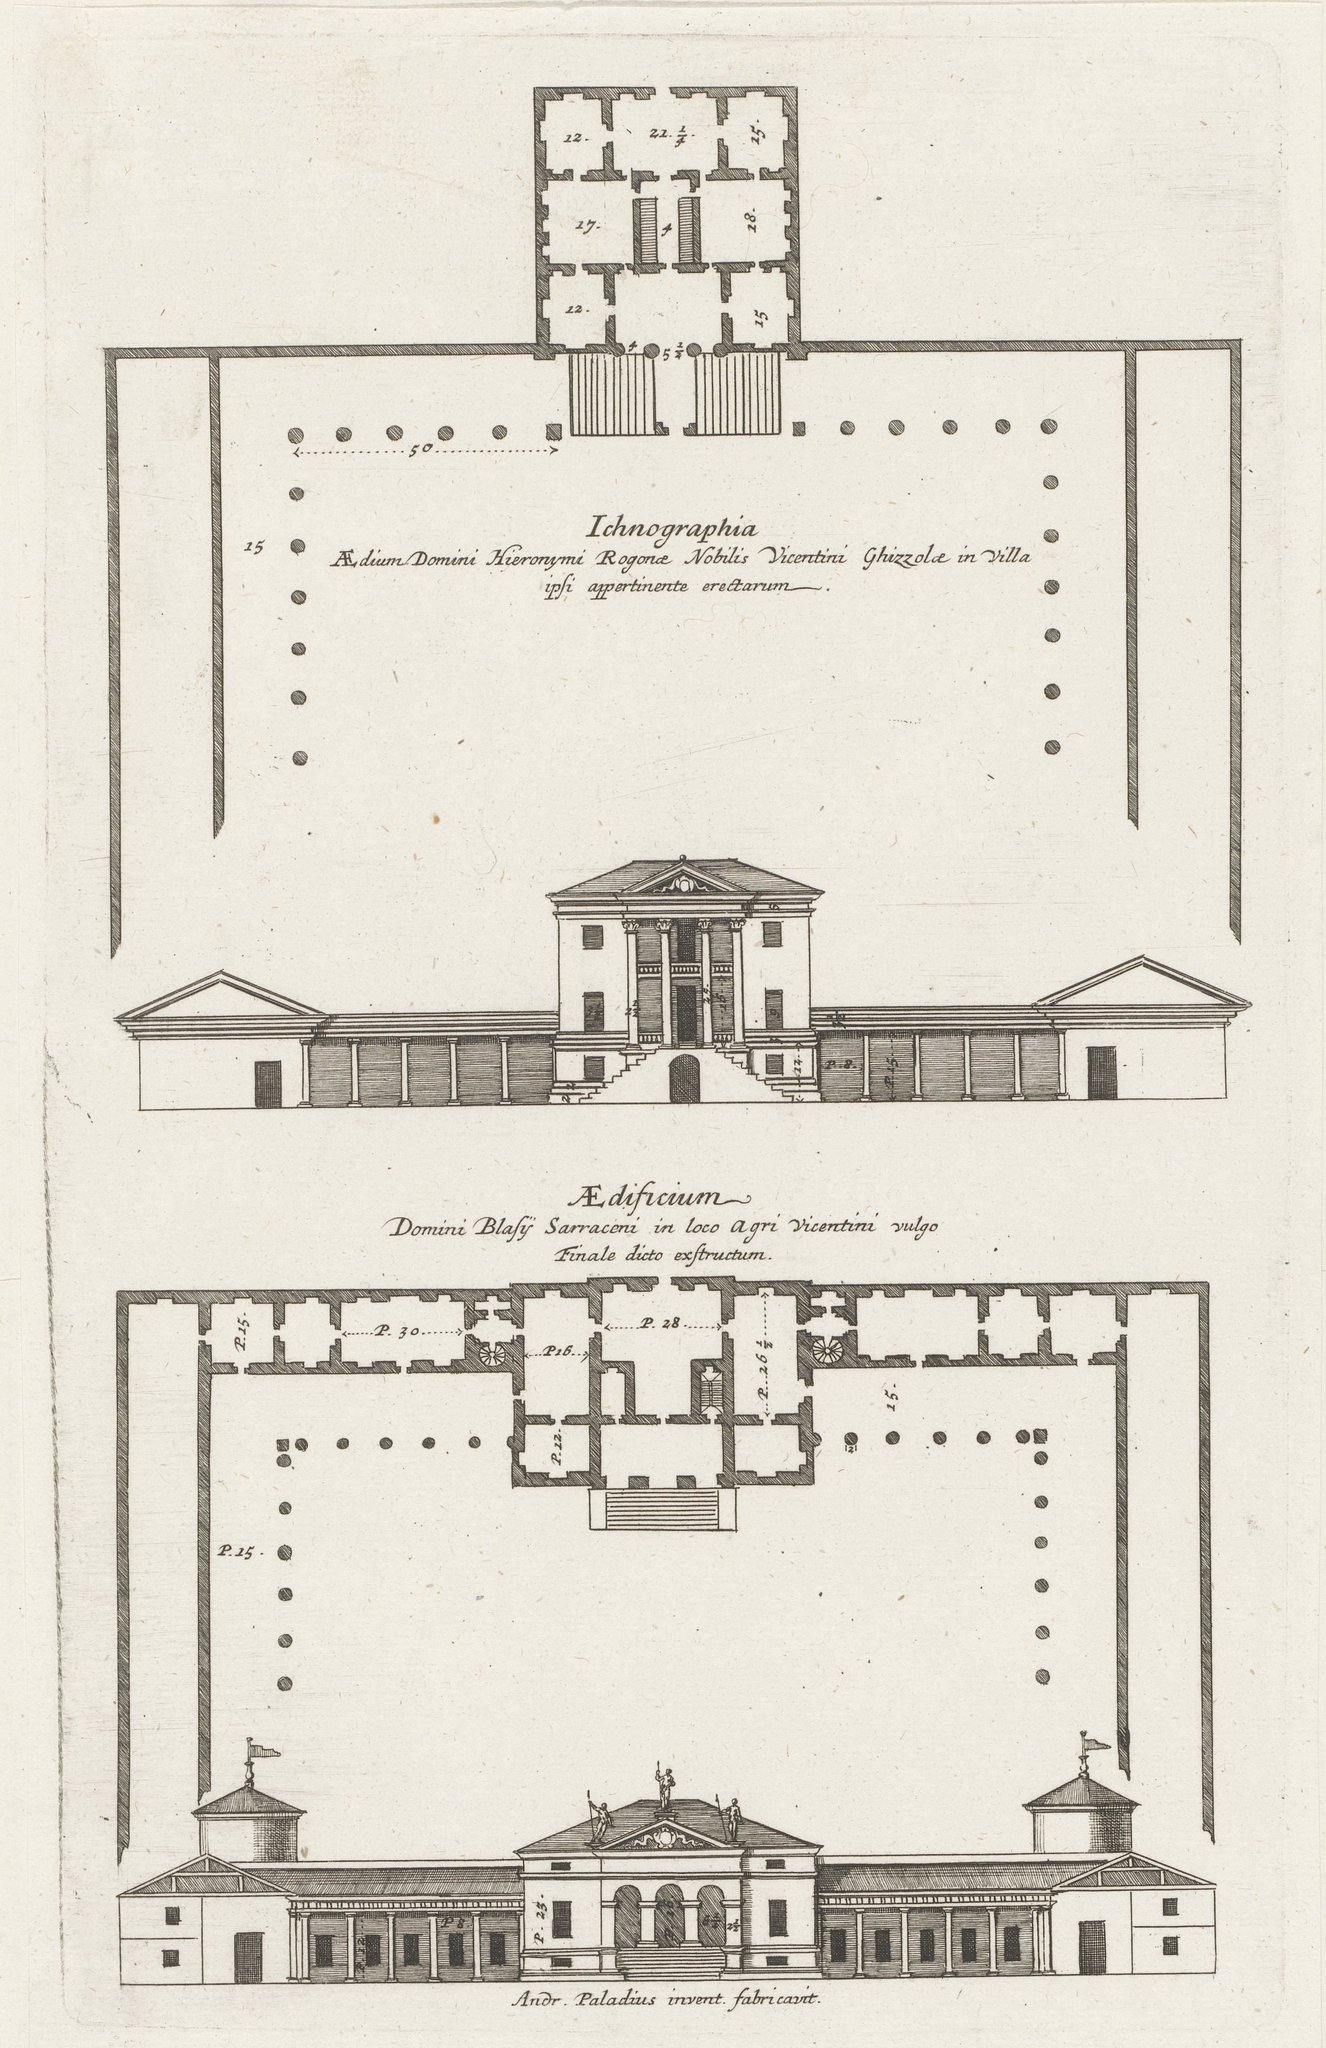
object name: print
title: Villa's van Palladio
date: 1600-1699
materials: paper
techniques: etching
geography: italy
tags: public baths